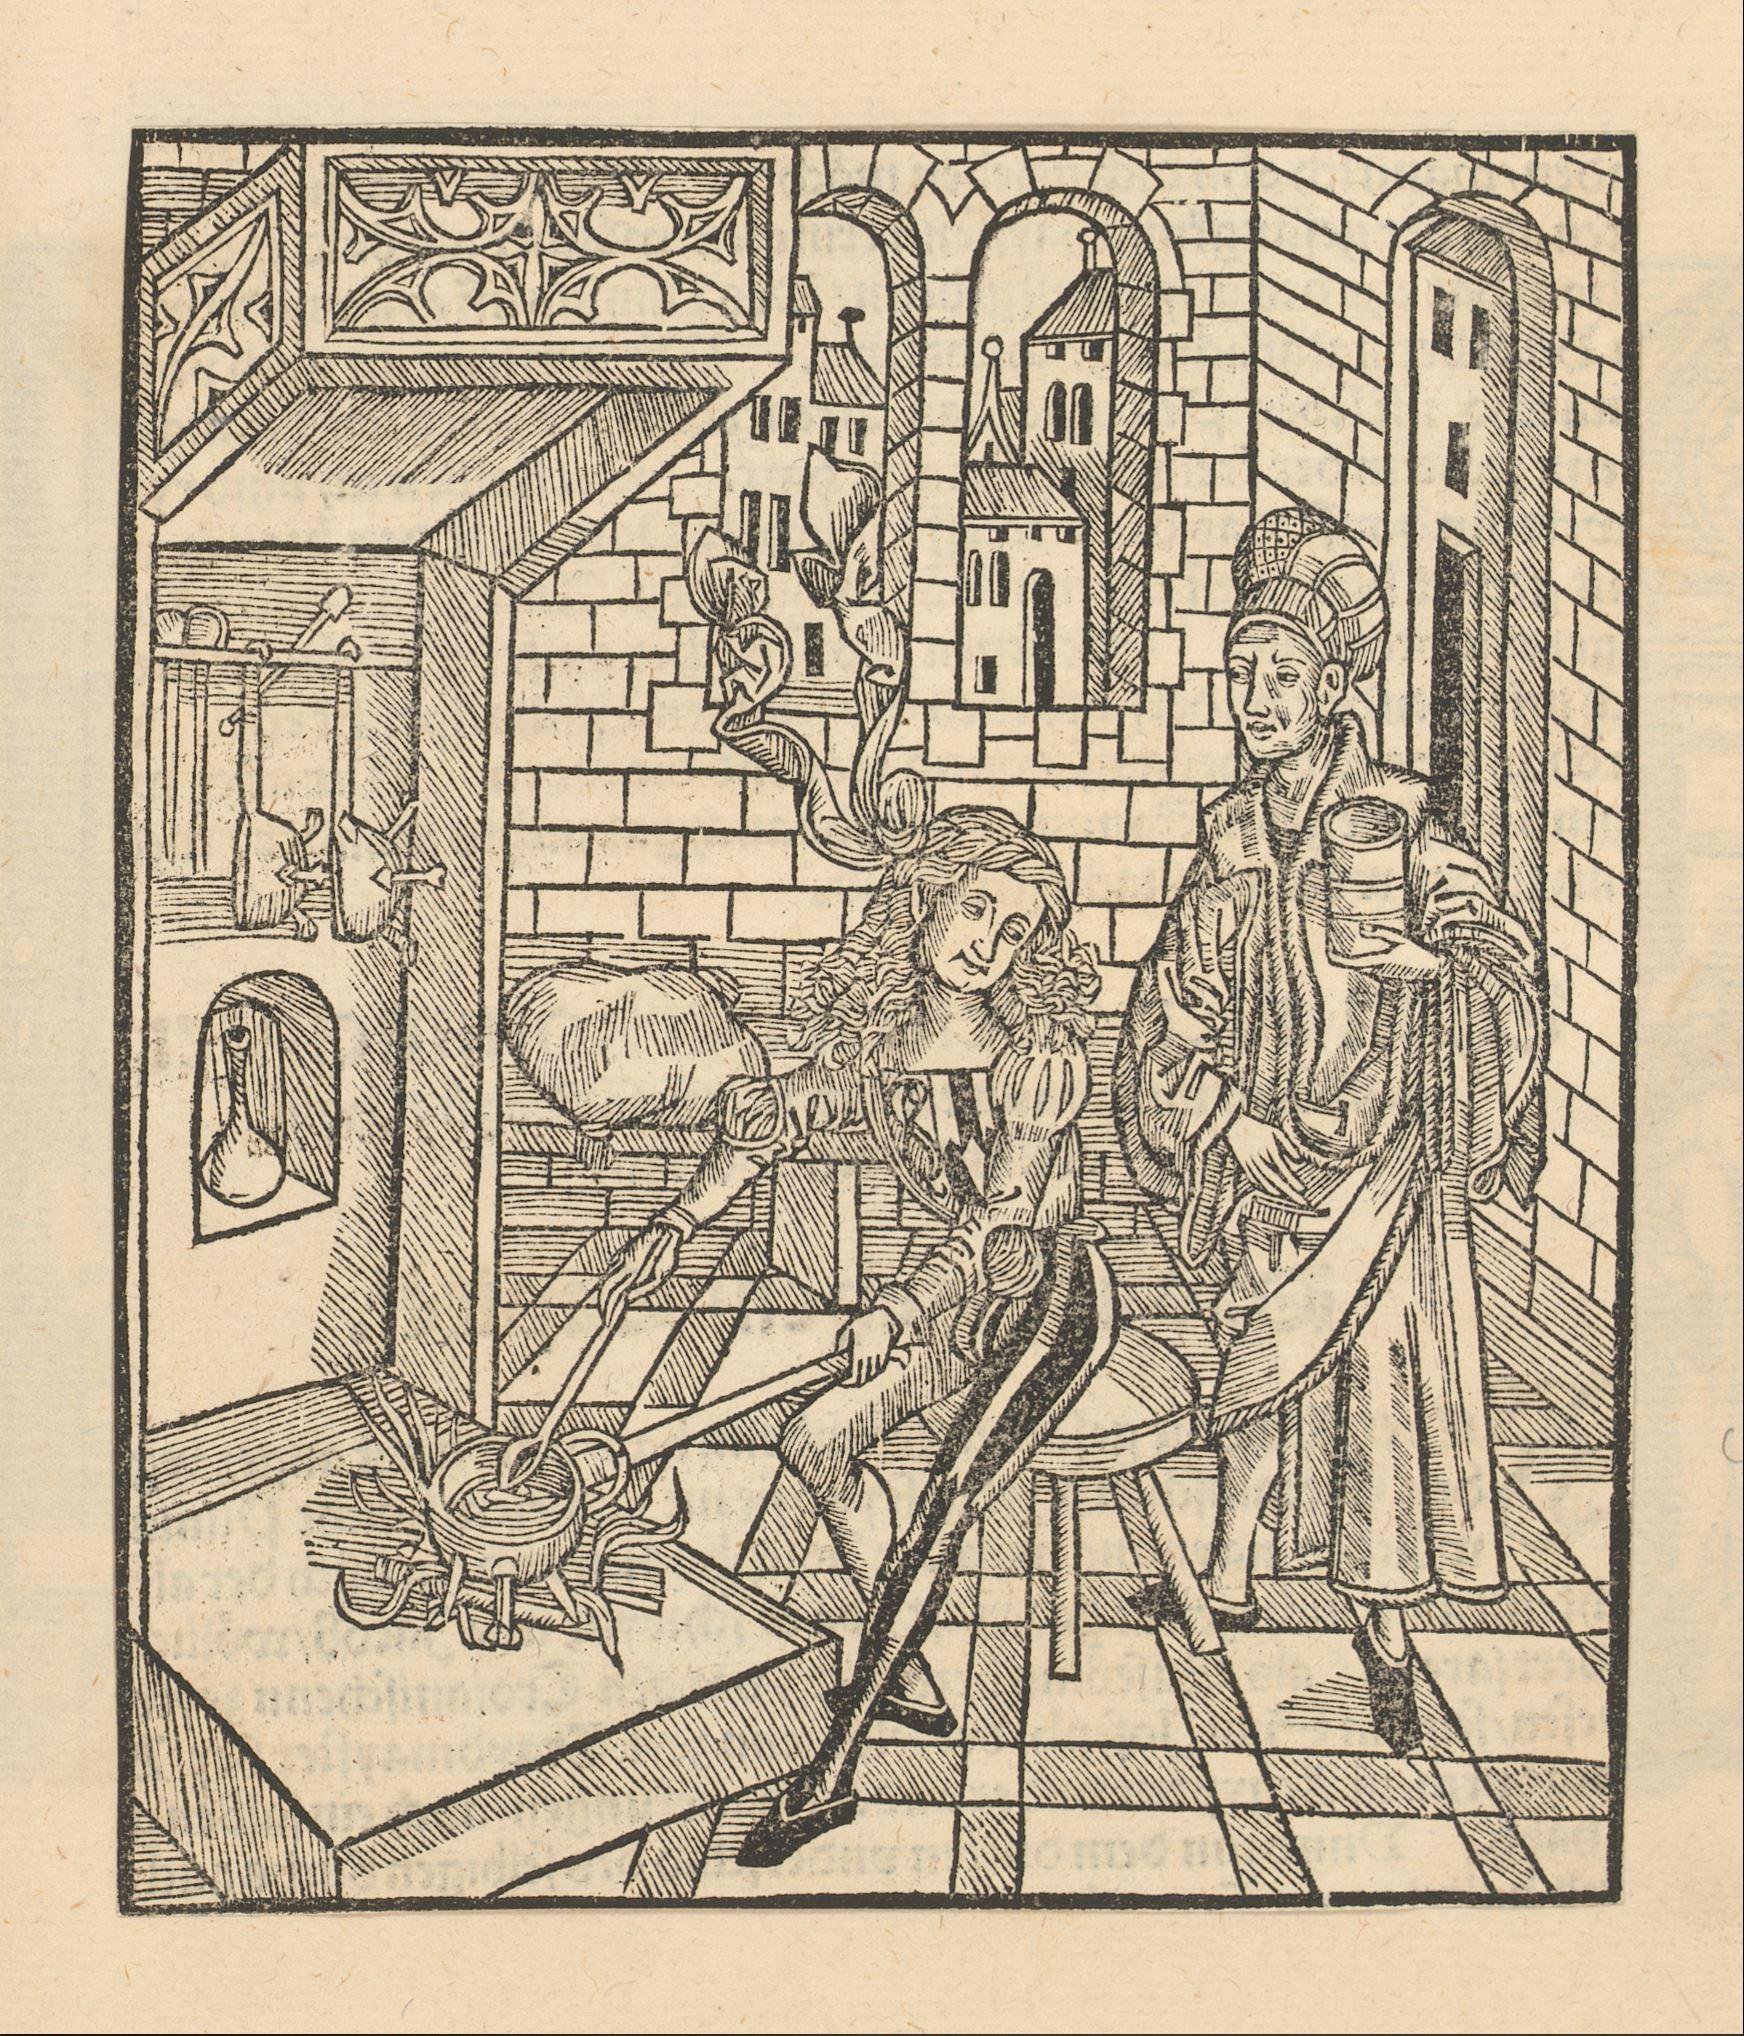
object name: book illustration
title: Twee mannen bij een kookvuur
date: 1490-1537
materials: paper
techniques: letterpress printing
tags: open fire, fire-place, stove (in kitchen)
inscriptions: annotation: ‘chirurgie’